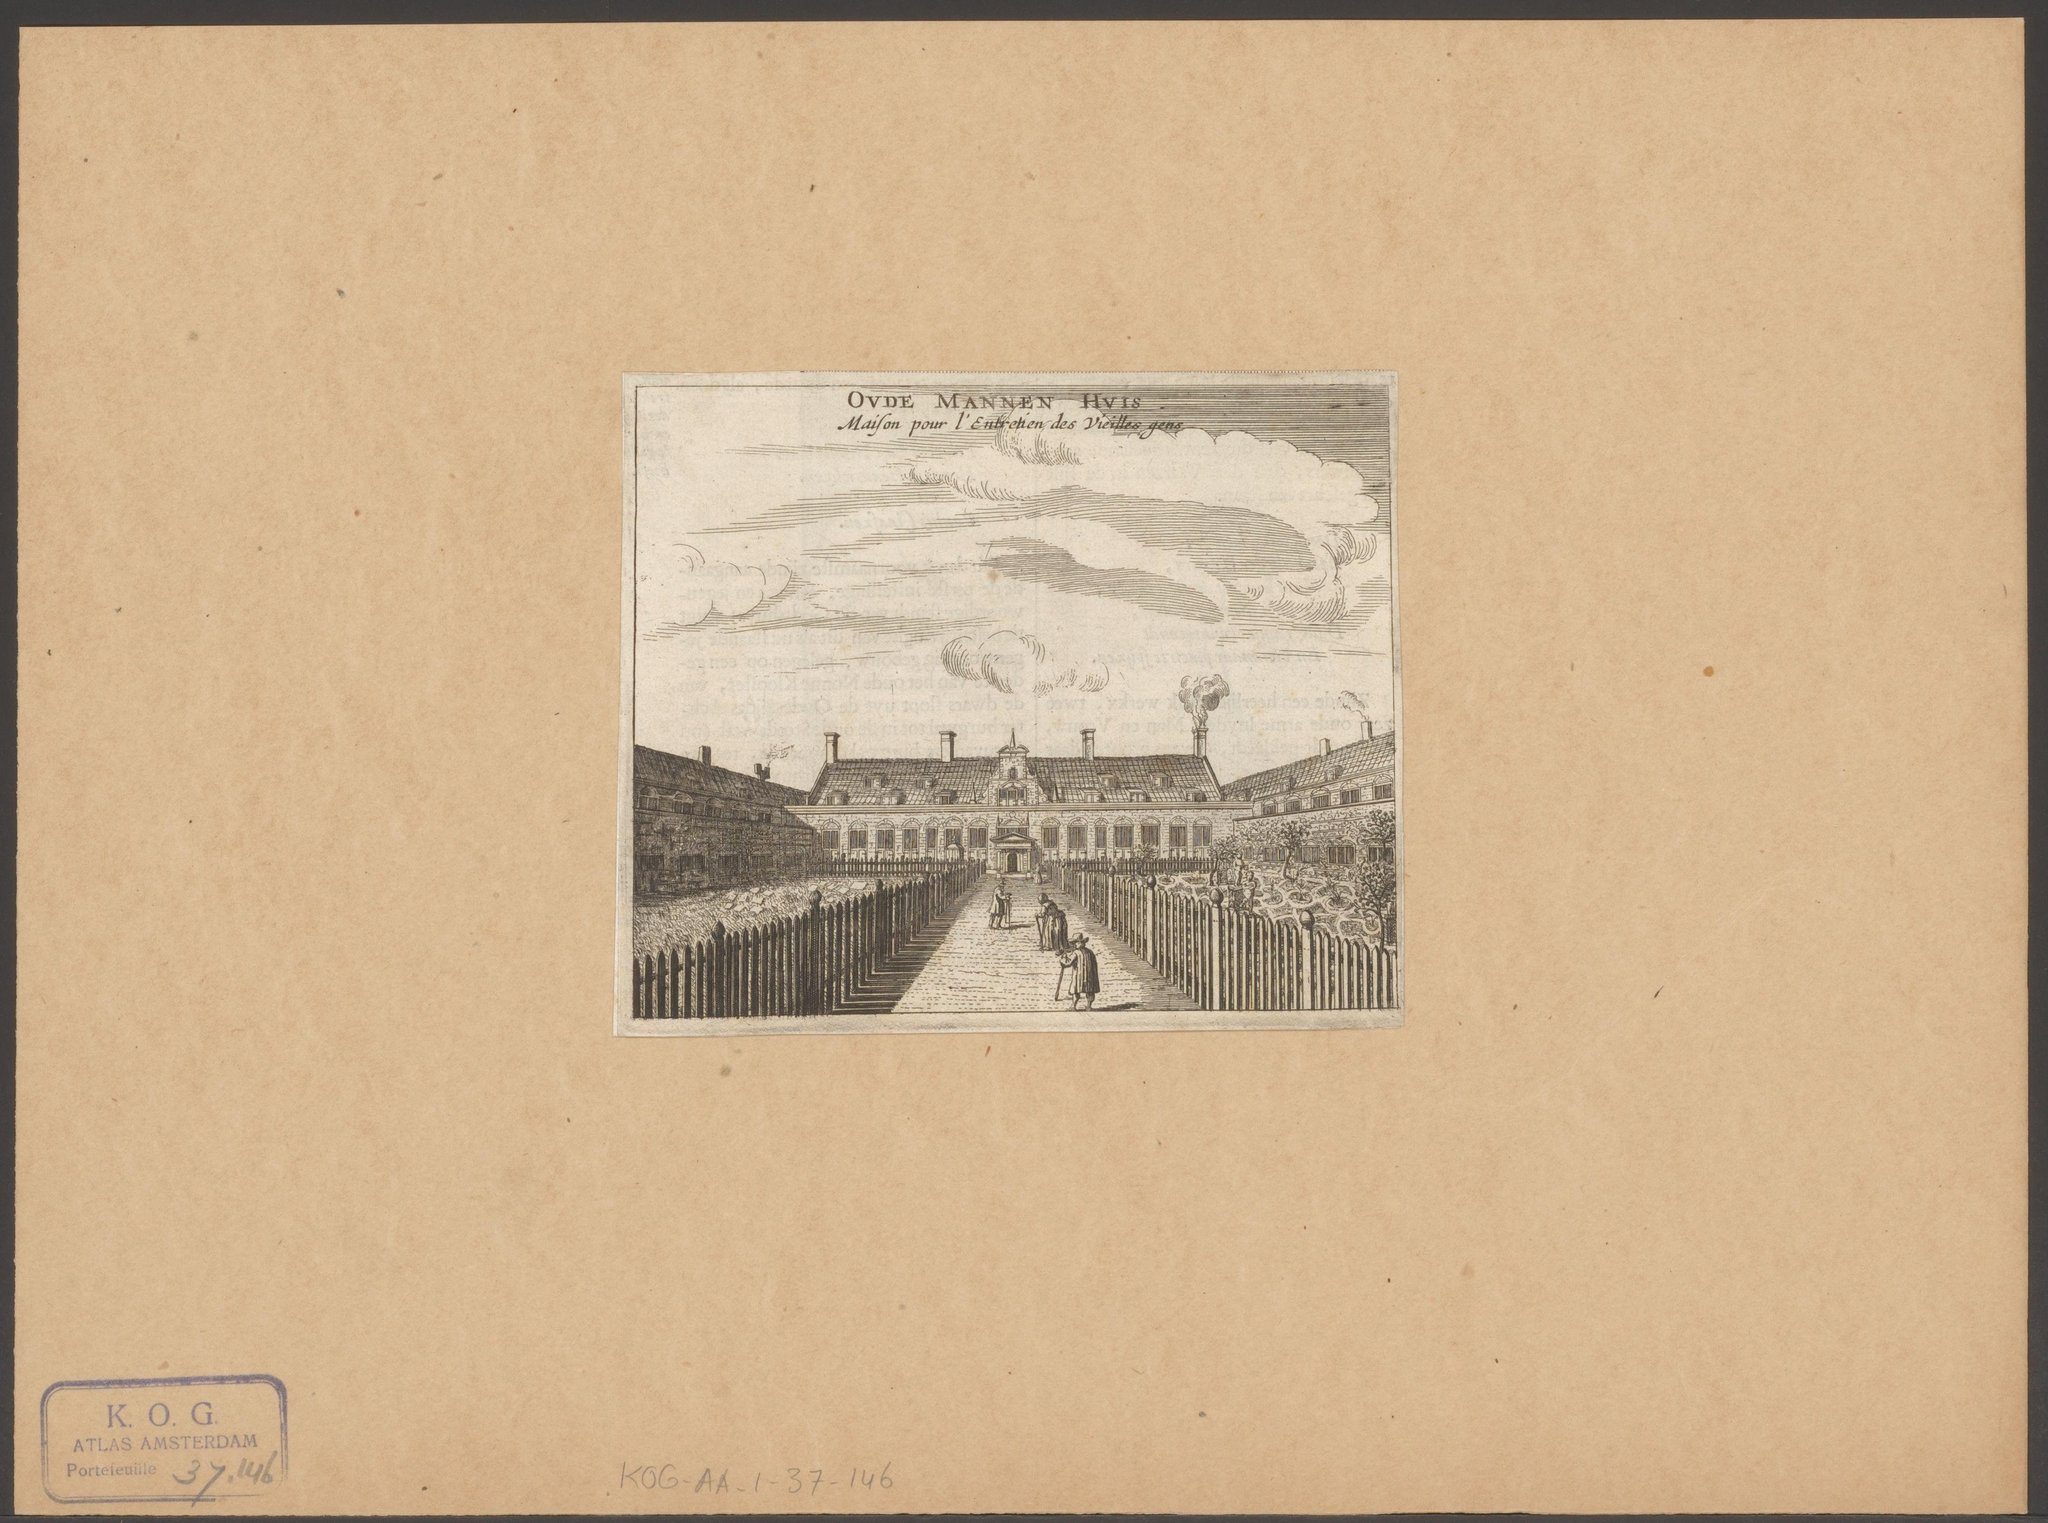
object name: print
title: Gezicht op de binnenplaats van het Oudemannenhuis te Amsterdam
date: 1665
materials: paper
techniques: engraving, etching, letterpress printing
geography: amsterdam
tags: courtyard, old-people's home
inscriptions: collector's mark: Lugt 1641b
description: Onderwerpsrubriek binnen de Atlas Amsterdam: Armwezen en liefdadige instellingen: I. Stadsinrichtingen: Oudemannenhuis aan de Oudezijds Achterburgwal.